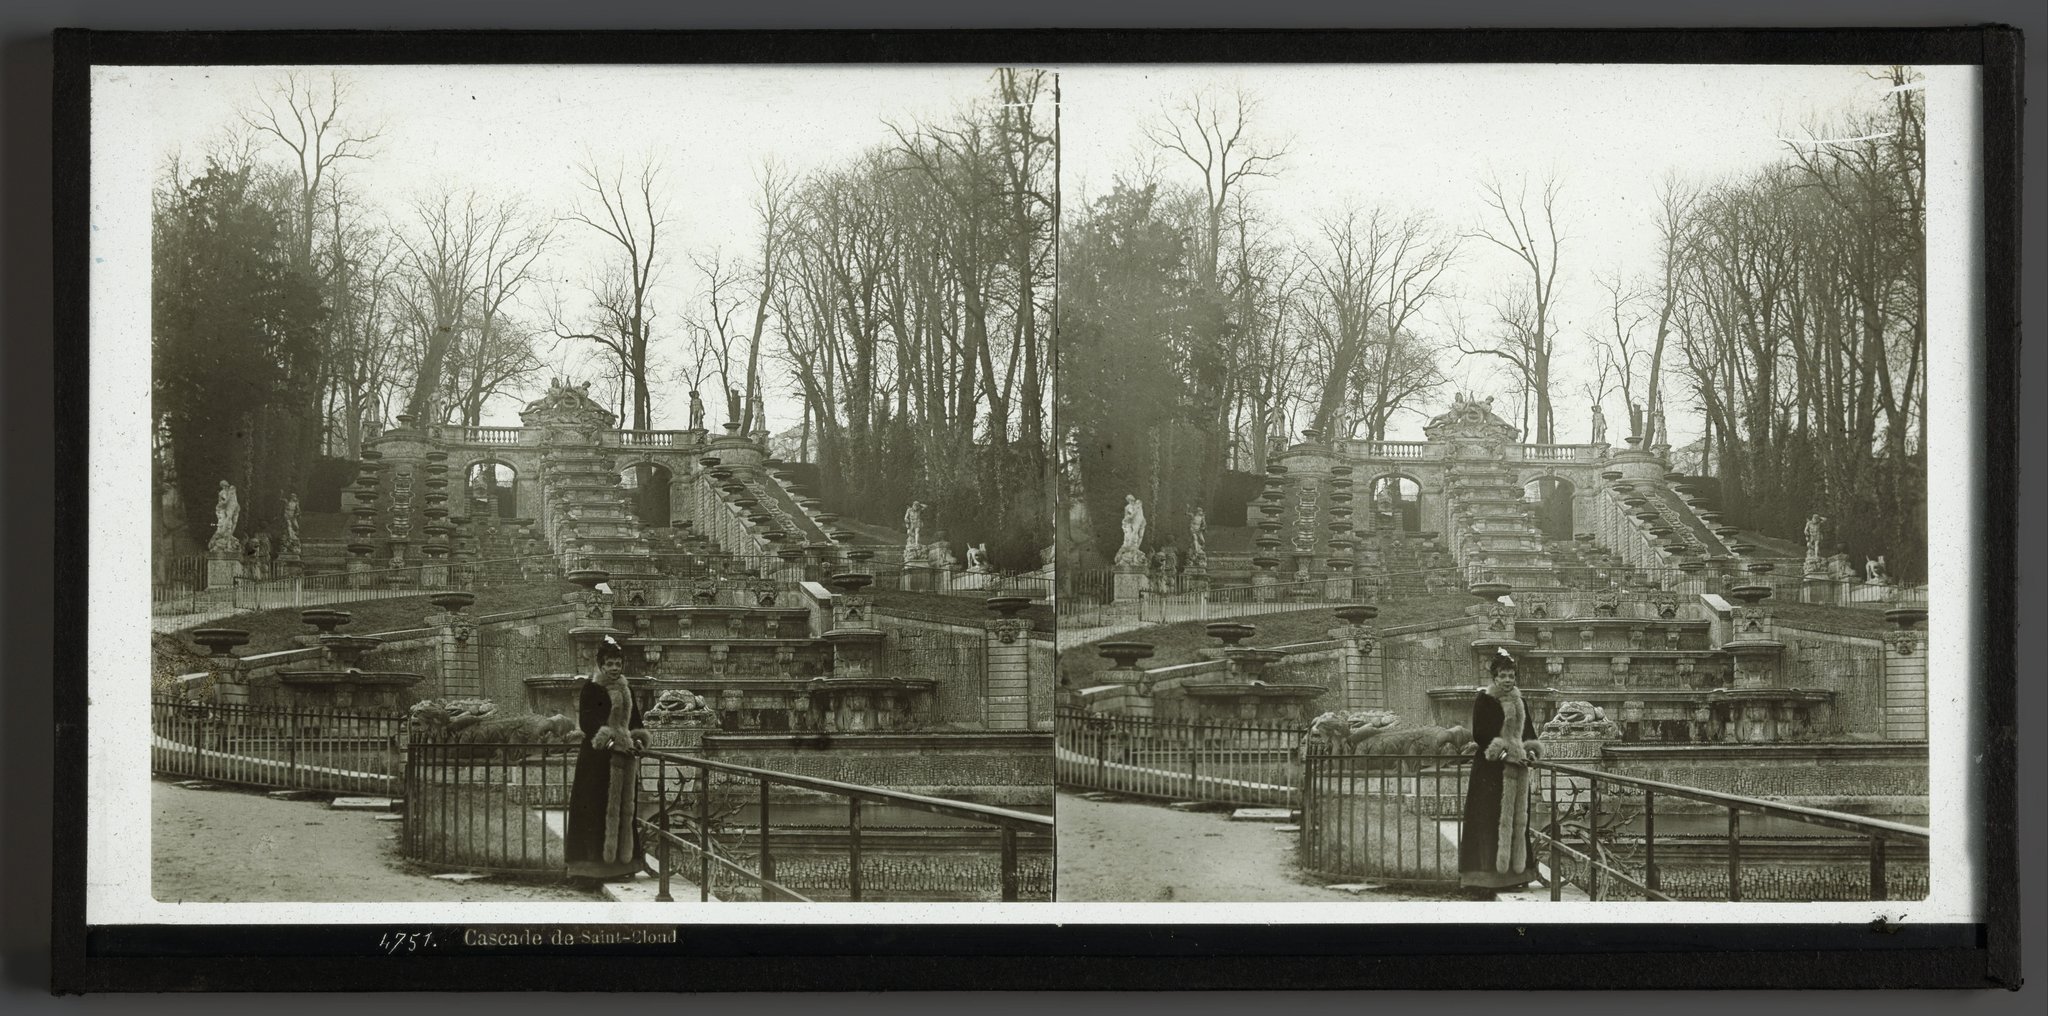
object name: stereoscopic photograph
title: Cascade de Saint-Cloud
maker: Anonymous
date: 1860-1890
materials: glass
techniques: slide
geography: saint-cloud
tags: garden cascade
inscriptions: number: ‘4751.’